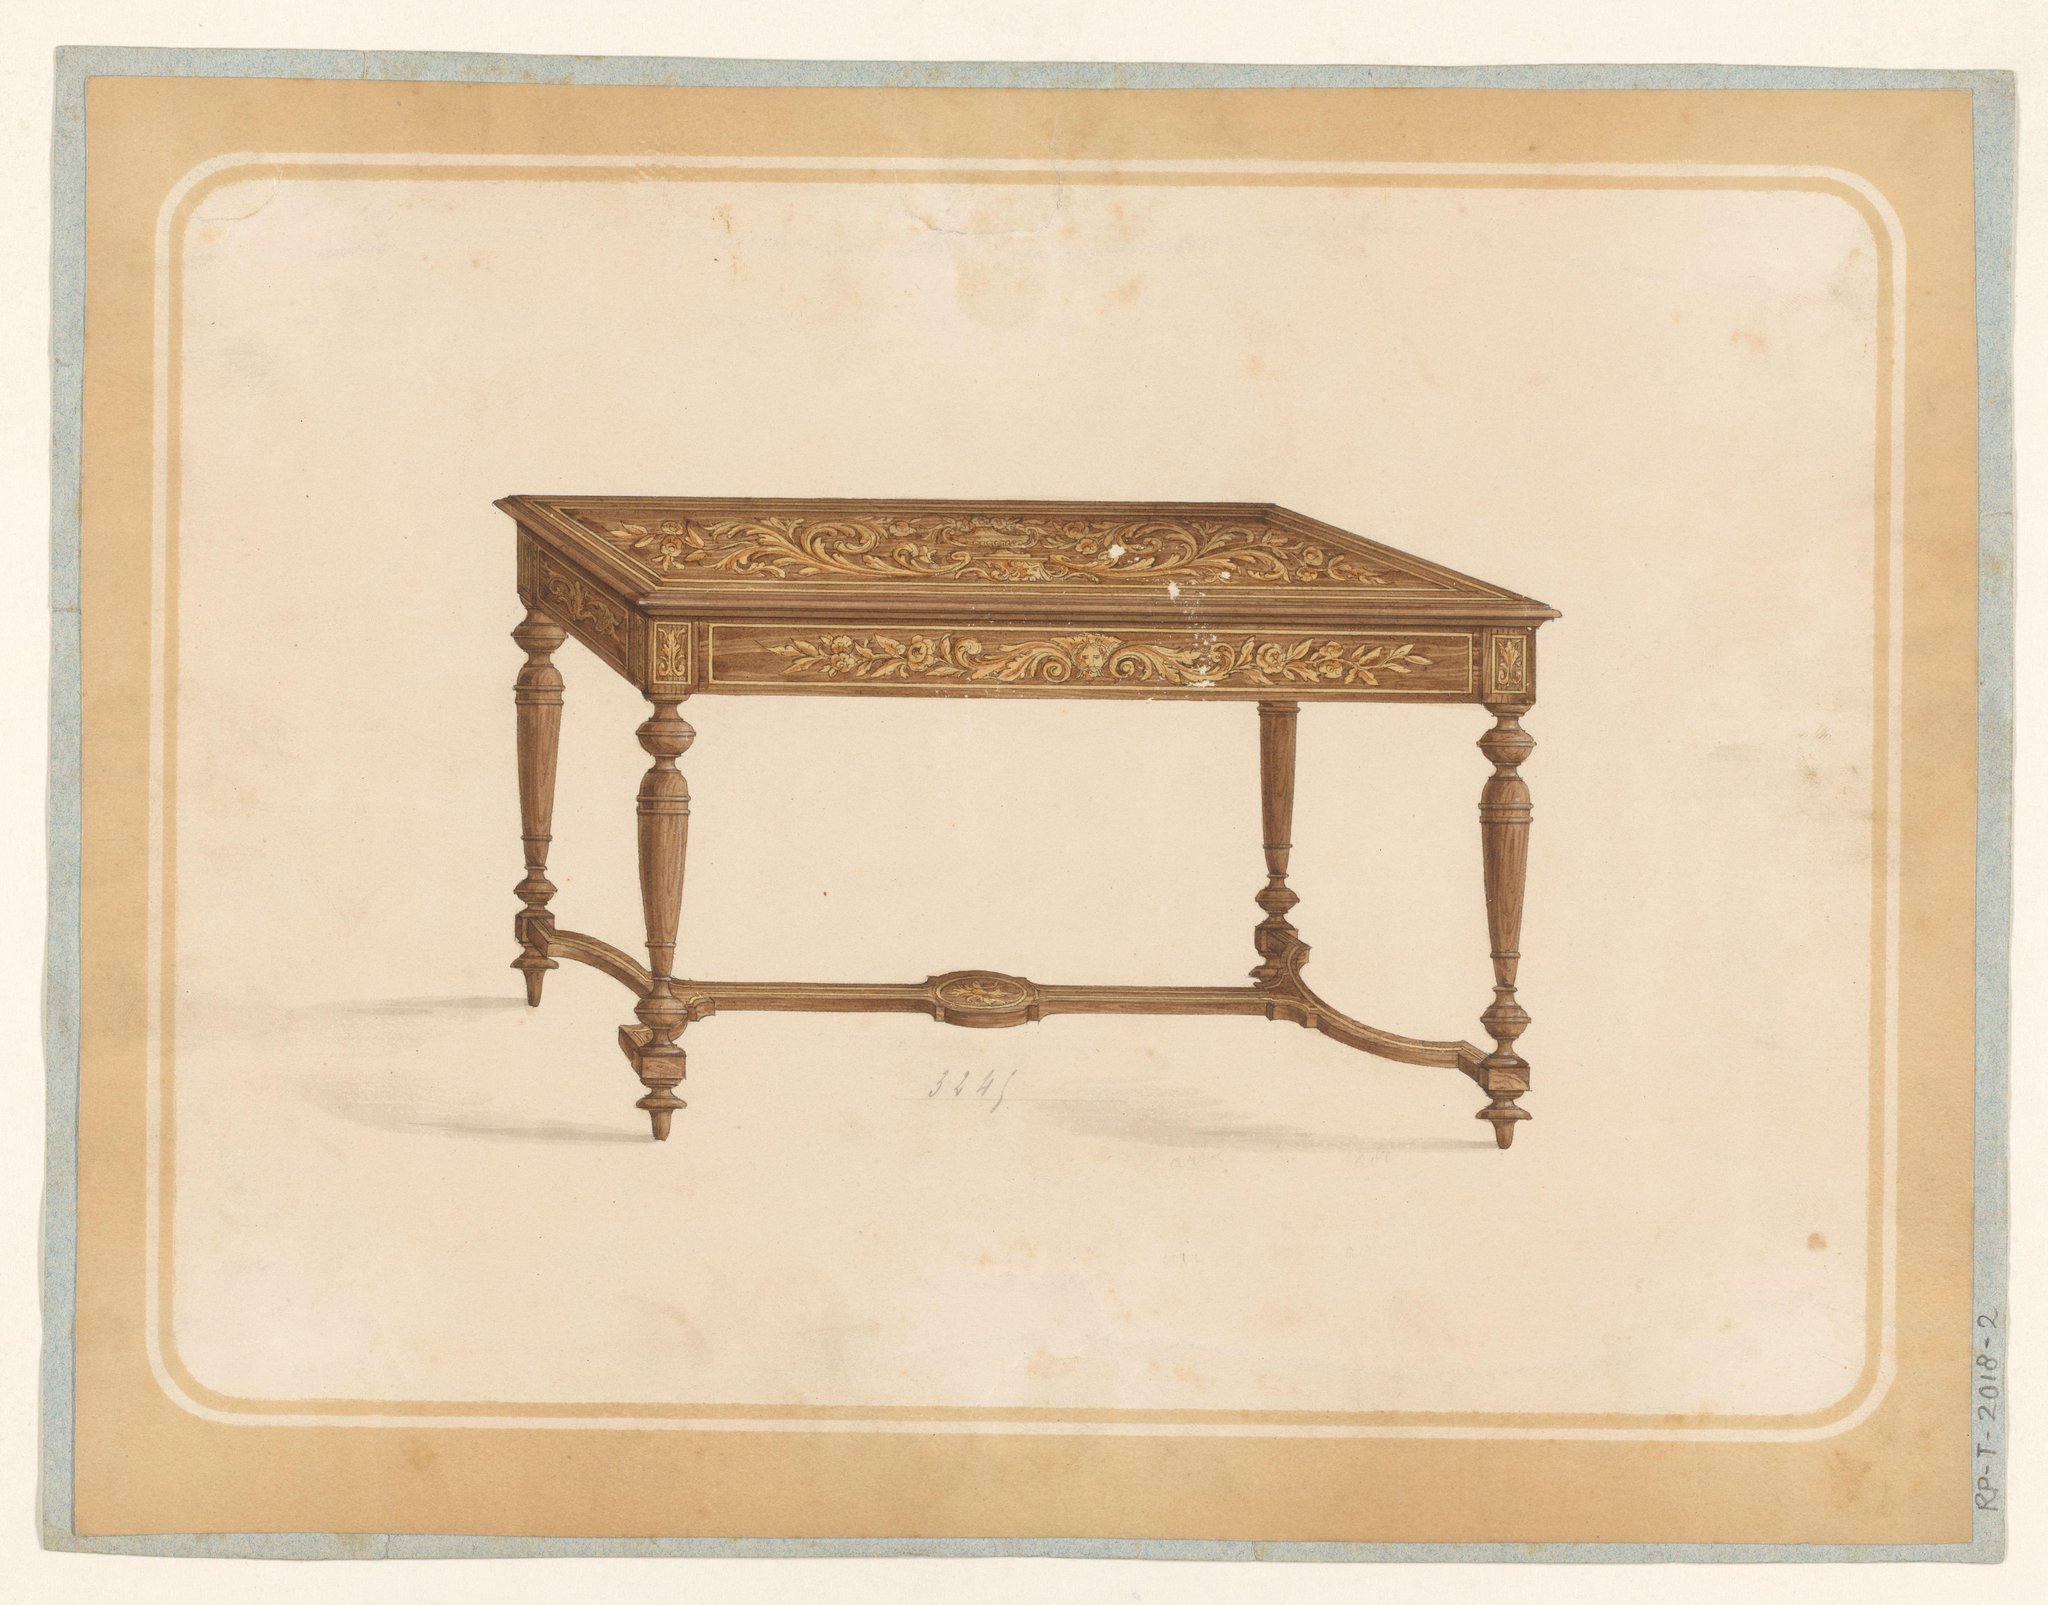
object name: drawing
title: Tafel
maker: Anonymous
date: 1835-1935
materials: ink, paper, watercolor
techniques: drawing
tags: decorative furniture, making marquetry ~ applied arts, table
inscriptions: number: ‘3245’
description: De tekening is op een blad geplakt. Op de andere zijde van dit blad is RP-T-2018-1 geplakt.